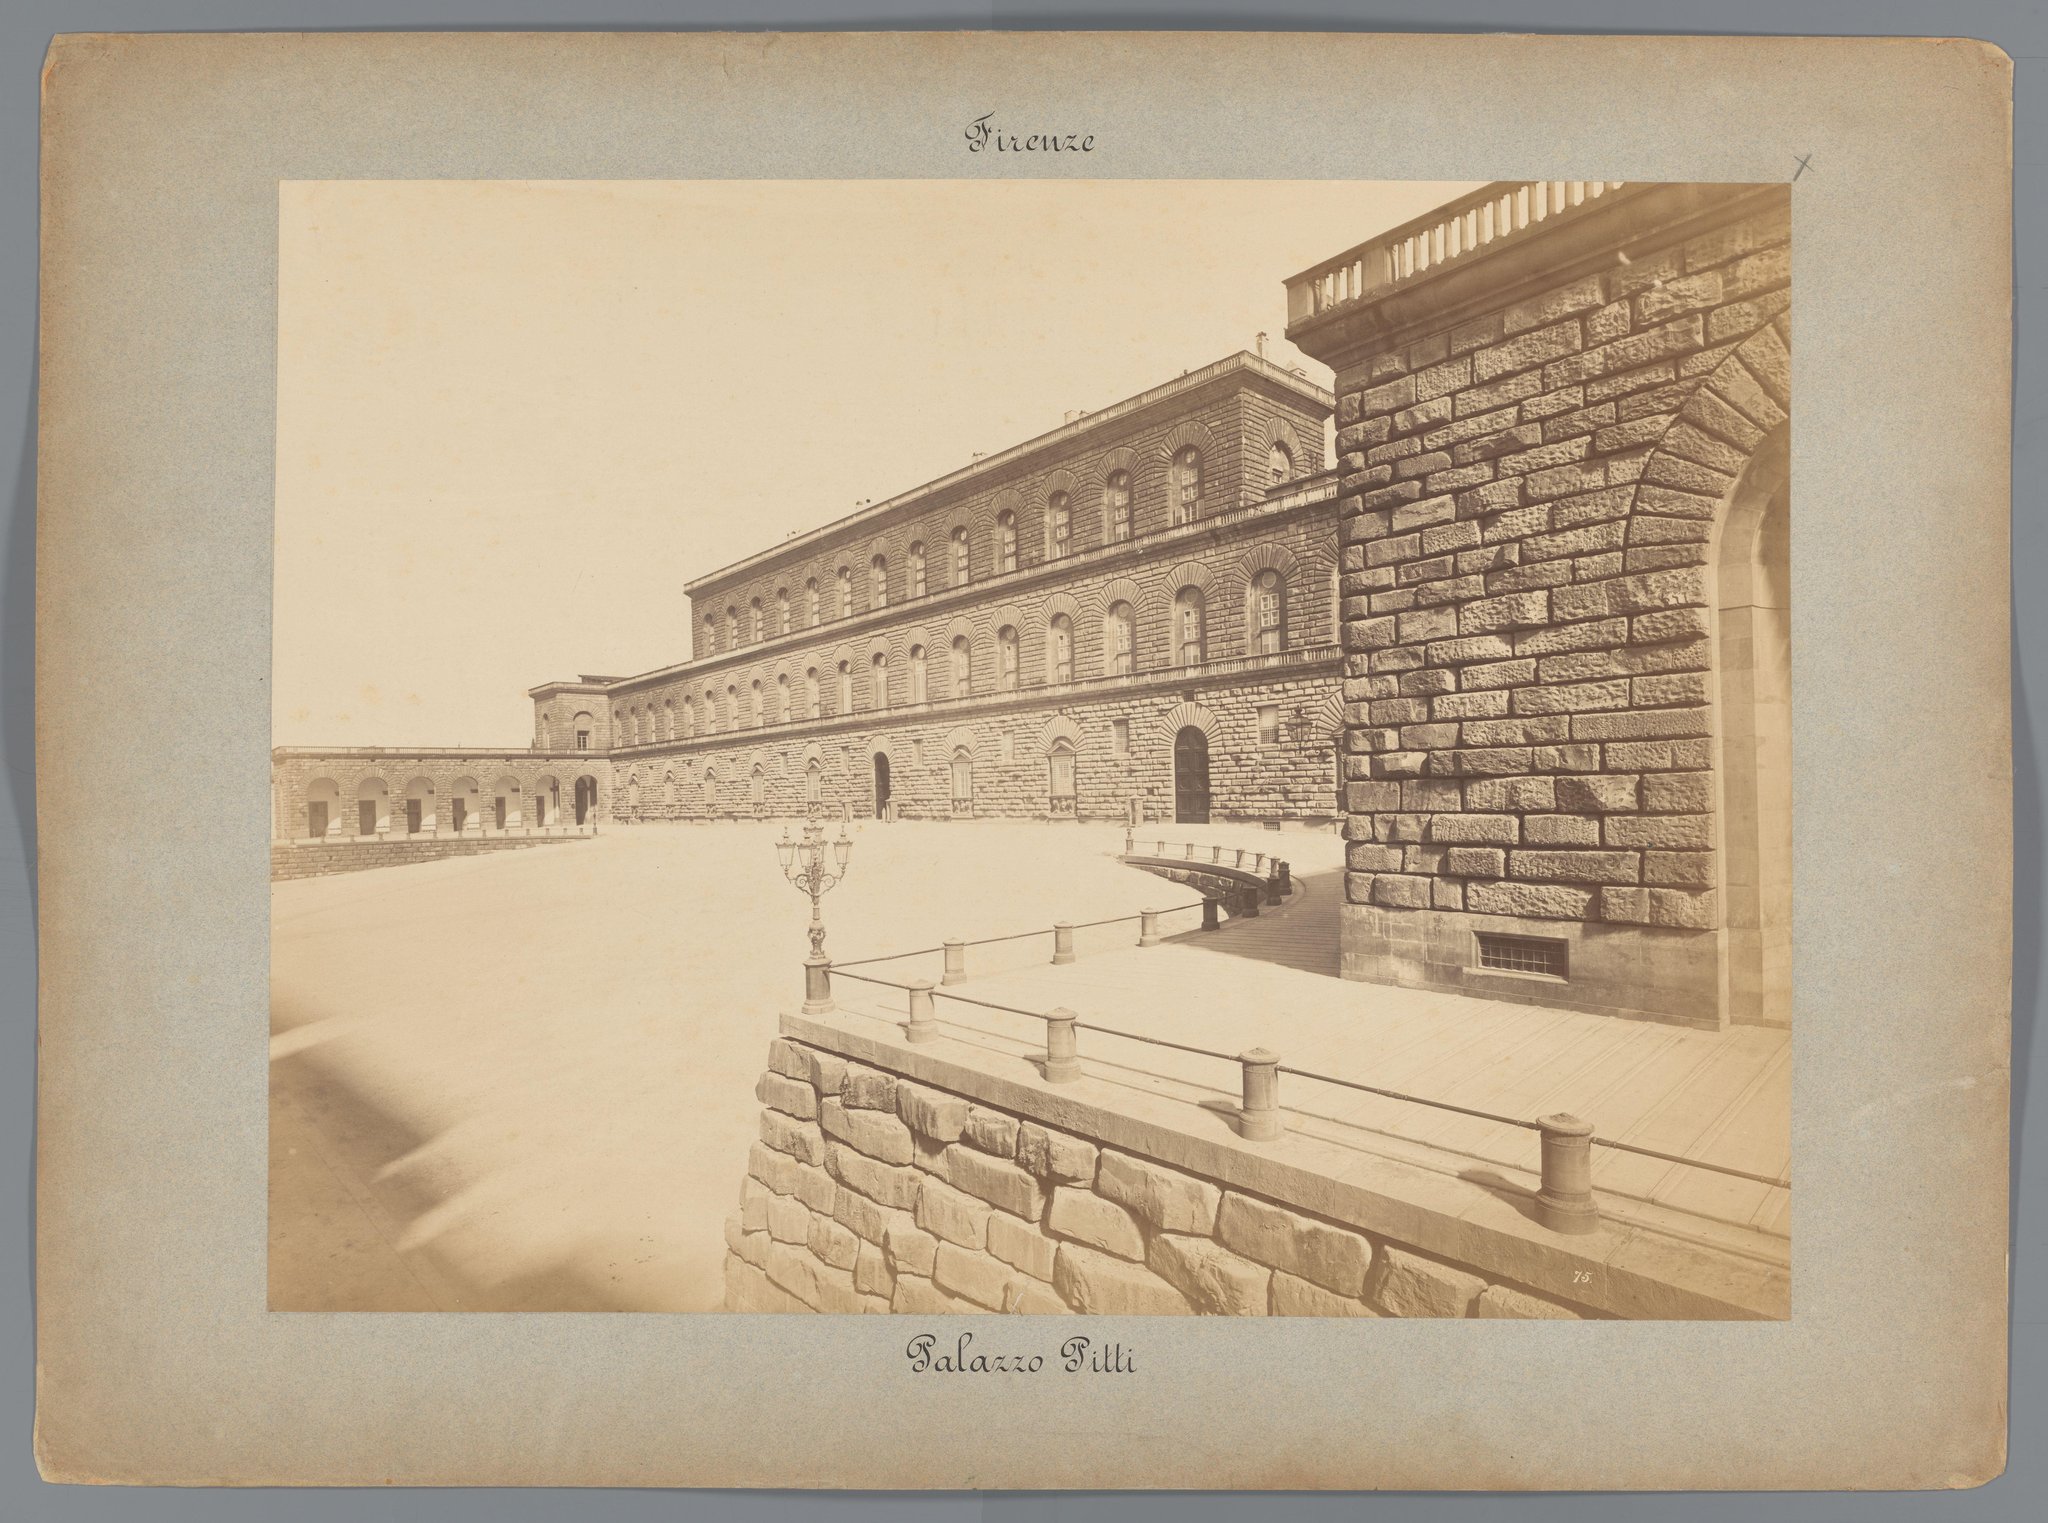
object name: photograph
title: Gezicht op de tuinzijde van het Palazzo Pitti te Florence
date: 1865-1900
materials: cardboard, photographic support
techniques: albumen print, calligraphy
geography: florence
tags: palazzo pitti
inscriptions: inscription: ‘Firenze / Palazzo Pitti’